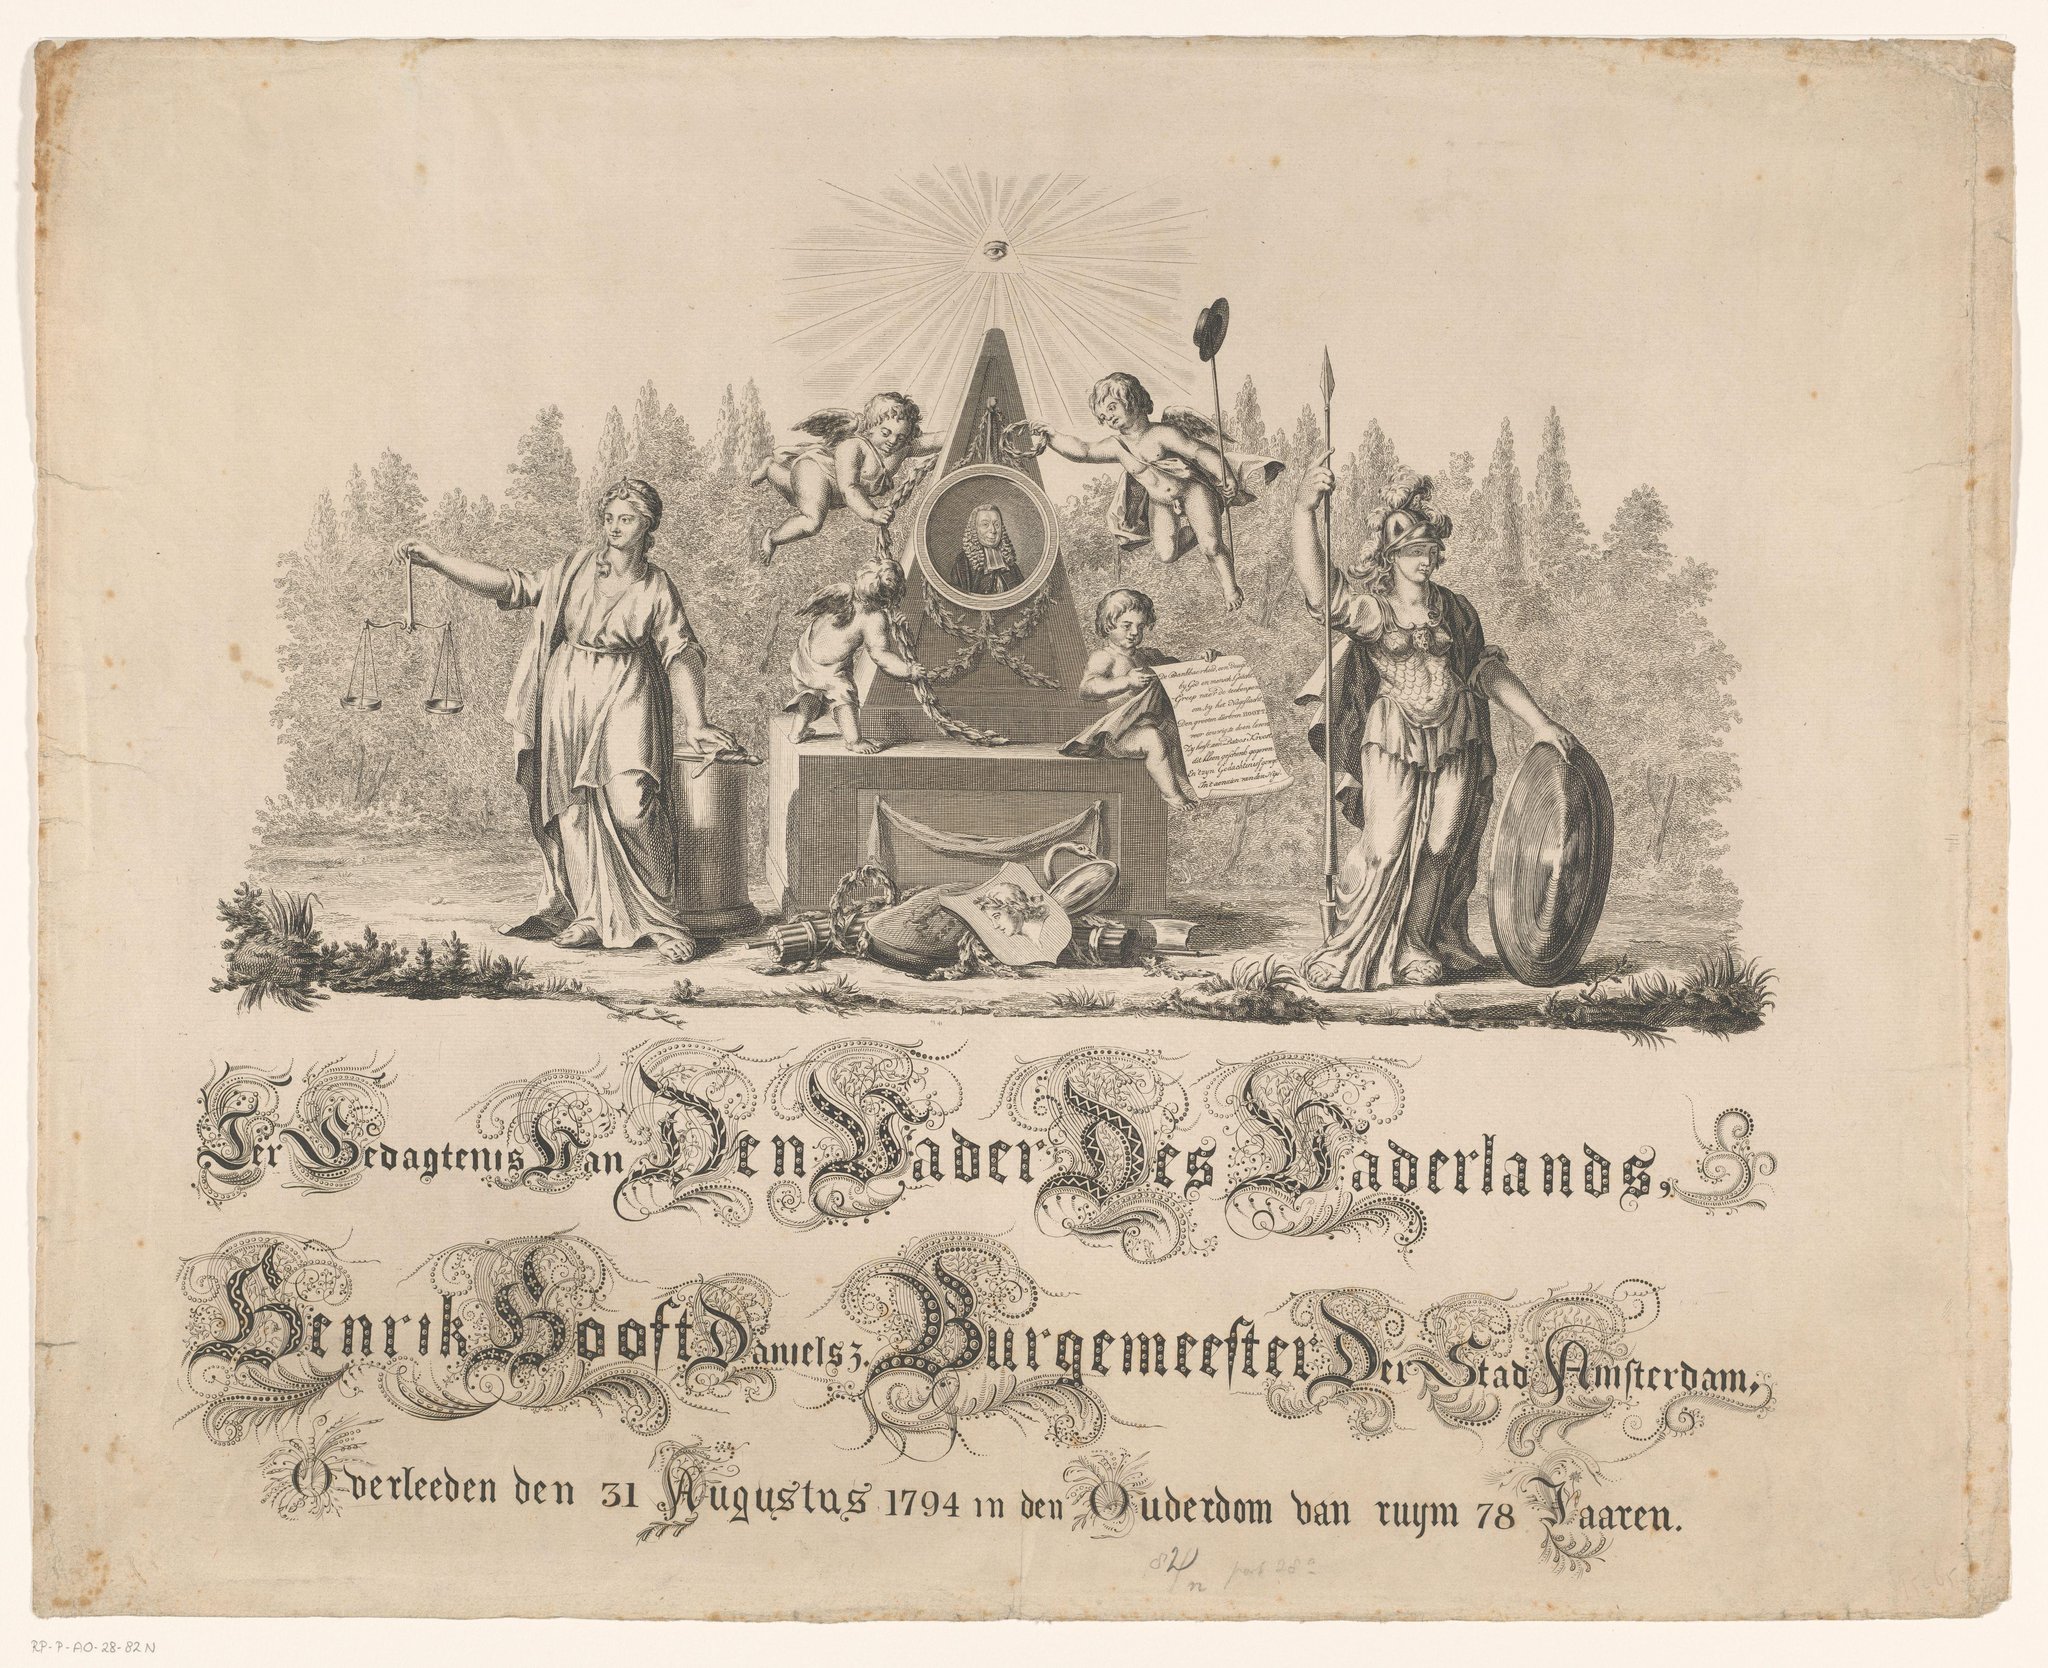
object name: calligraphy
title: Allegorie op het overlijden van Hendrik Danielsz. Hooft, 1794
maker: Anonymous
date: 1787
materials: paper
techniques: engraving, etching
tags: mayor, hendrik danielsz. hooft, justice, 'justitia'; 'giustitia divina' (ripa) ~ one of the four cardinal virtues, historical persons, calligraphy, the all-seeing eye, triangle with eye ~ symbol of god the father, freedom, liberty; 'libertà' (ripa) (+ abstract concept represented by female figure)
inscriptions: collector's mark: Lugt 2228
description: Allegorisch grafmonument bij het overlijden van Hendrik Danielsz. Hooft, oud-burgemeester van Amsterdam, op 31 augustus 1794. Portretmedaillon met pruik op obelisk, drie putti omhangen het monument met eikenloof. Links de Rechtvaardigheid, rechts de Vrijheid. In de lucht het Alziende Oog. Met gekalligrafeerd opschrift.